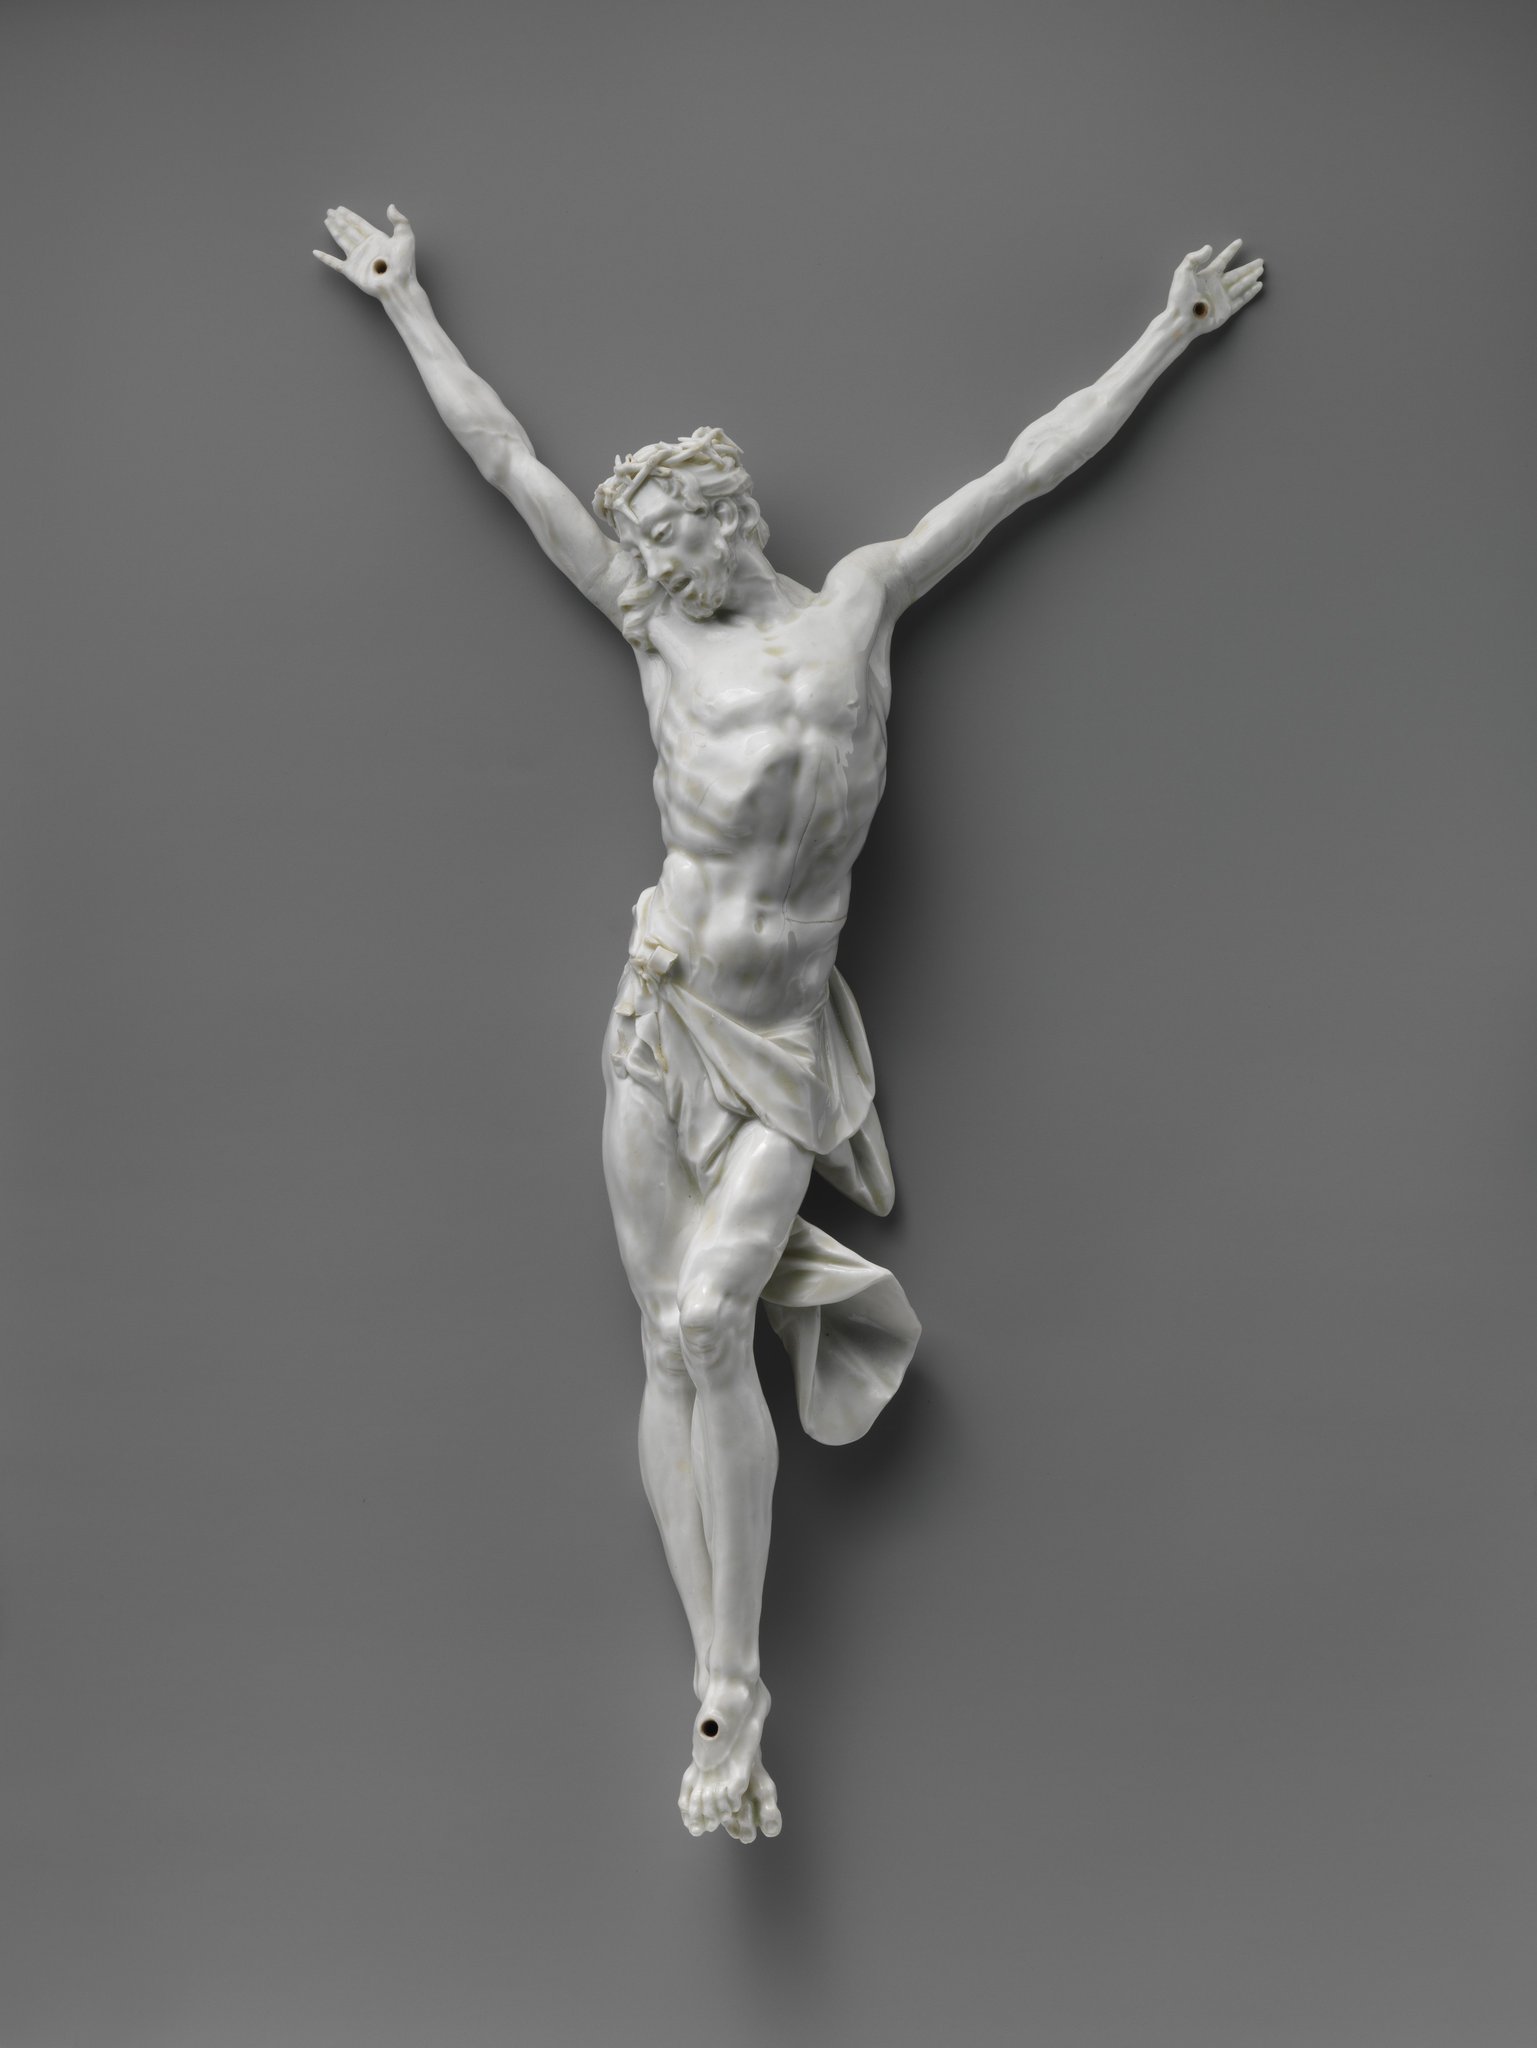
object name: figure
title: Corpus from a Crucifix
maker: nymphenburg porcelain manufactory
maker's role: manufactory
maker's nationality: german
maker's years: 1747-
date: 1755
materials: hard paste porcelain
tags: men